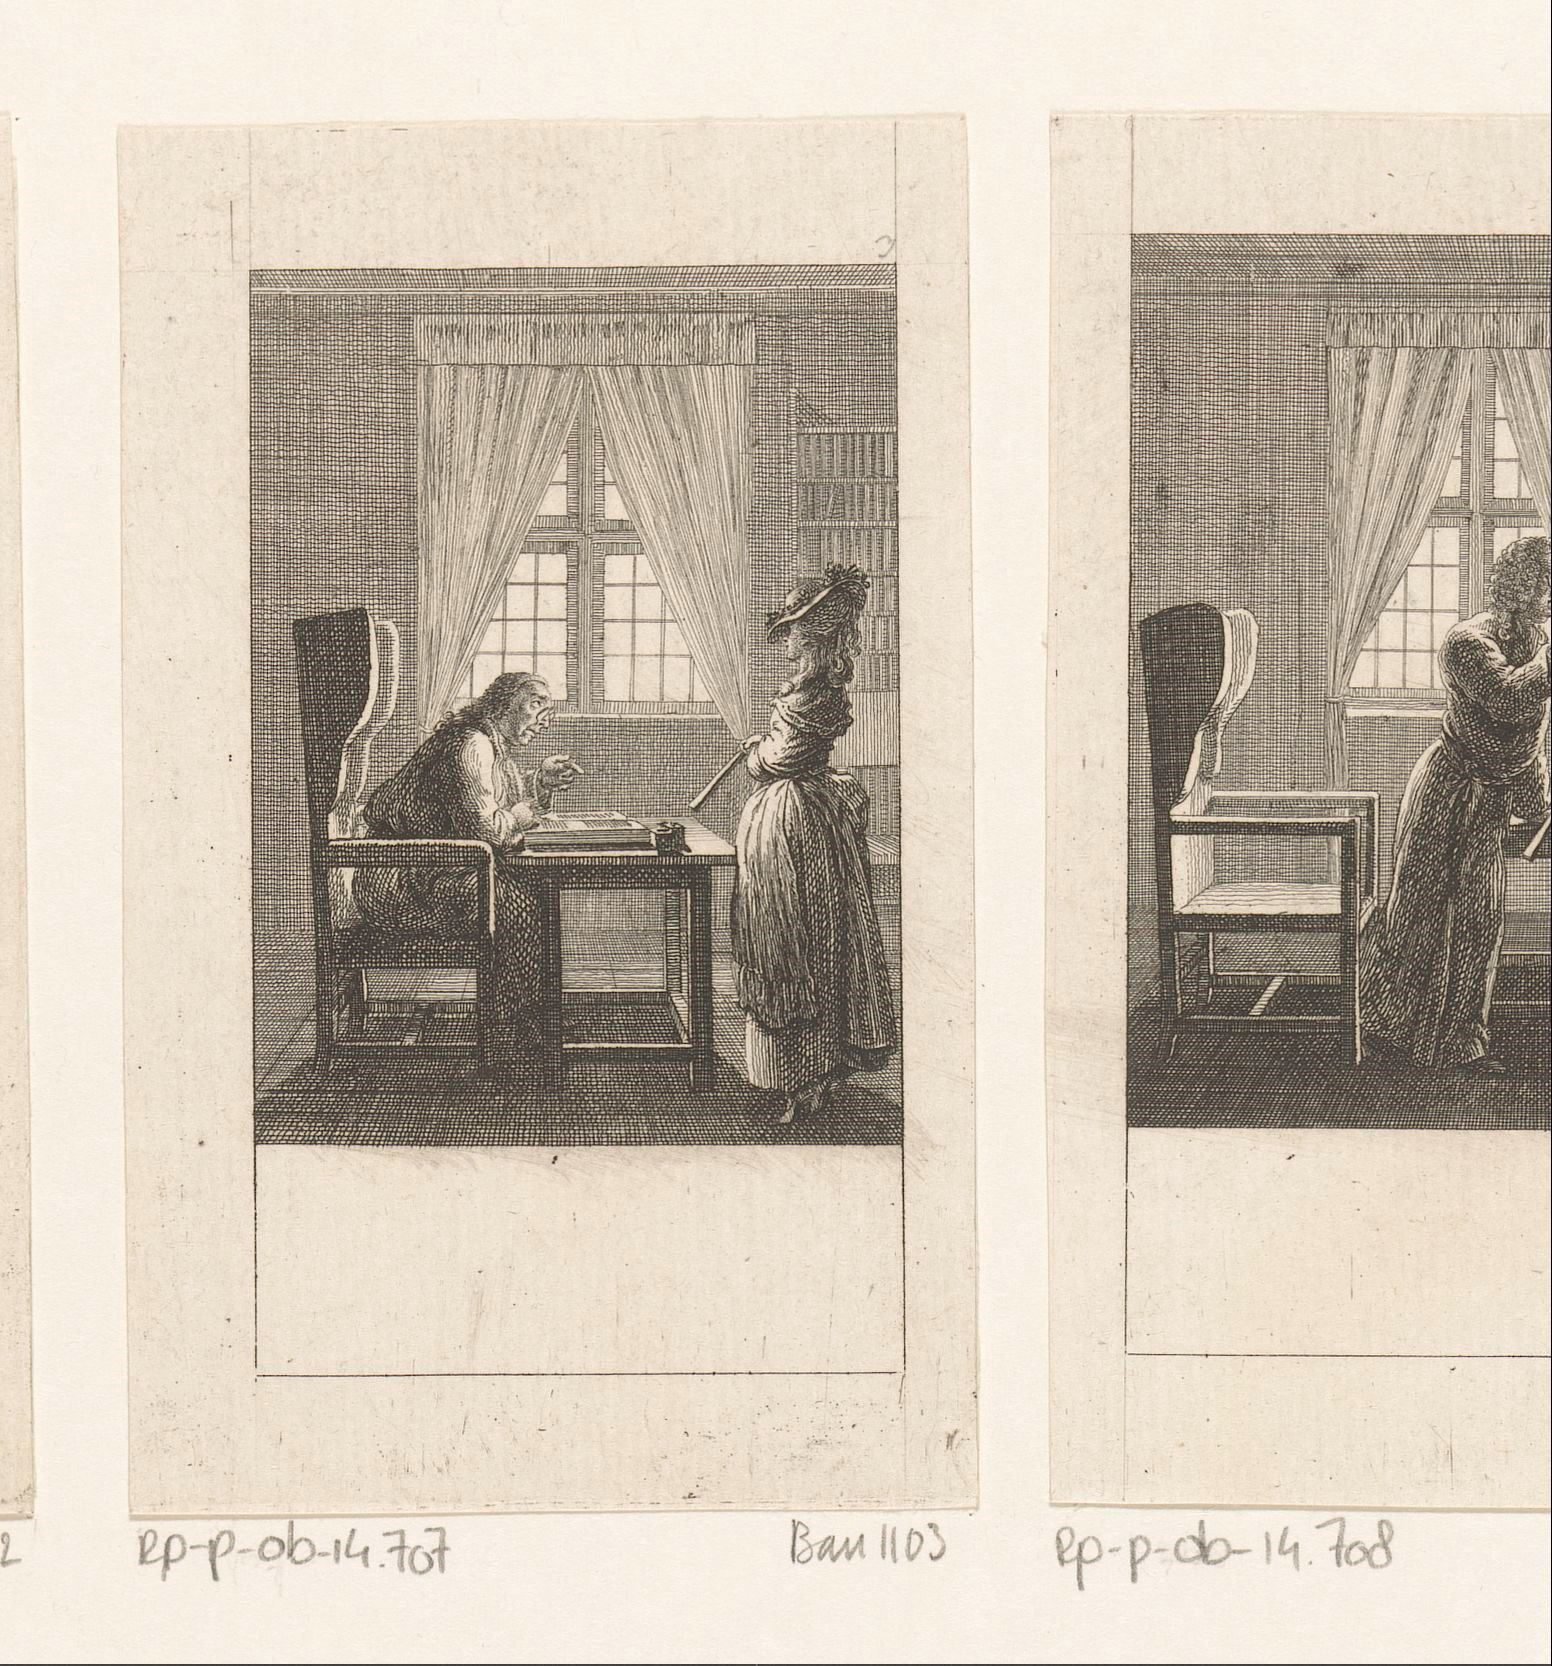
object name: print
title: Kamerdame Louise op het kantoor van Storr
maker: daniel nikolaus chodowiecki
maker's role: draughtsman, print maker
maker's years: 1726-1801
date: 1784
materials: paper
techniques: etching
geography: berlin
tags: literature, book-keeping, accountant, maid ~ house personnel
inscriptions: collector's mark: Lugt 2228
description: Vervaardigd voor Christian Friedrich Bretzners 'Eheprocurator'. Latere staat gebruikt voor: Konigl. Grosbrit. Genealogischen Kalender auf das Jahr 1785. Lauenburg: J. G. Berenberg, 1784.